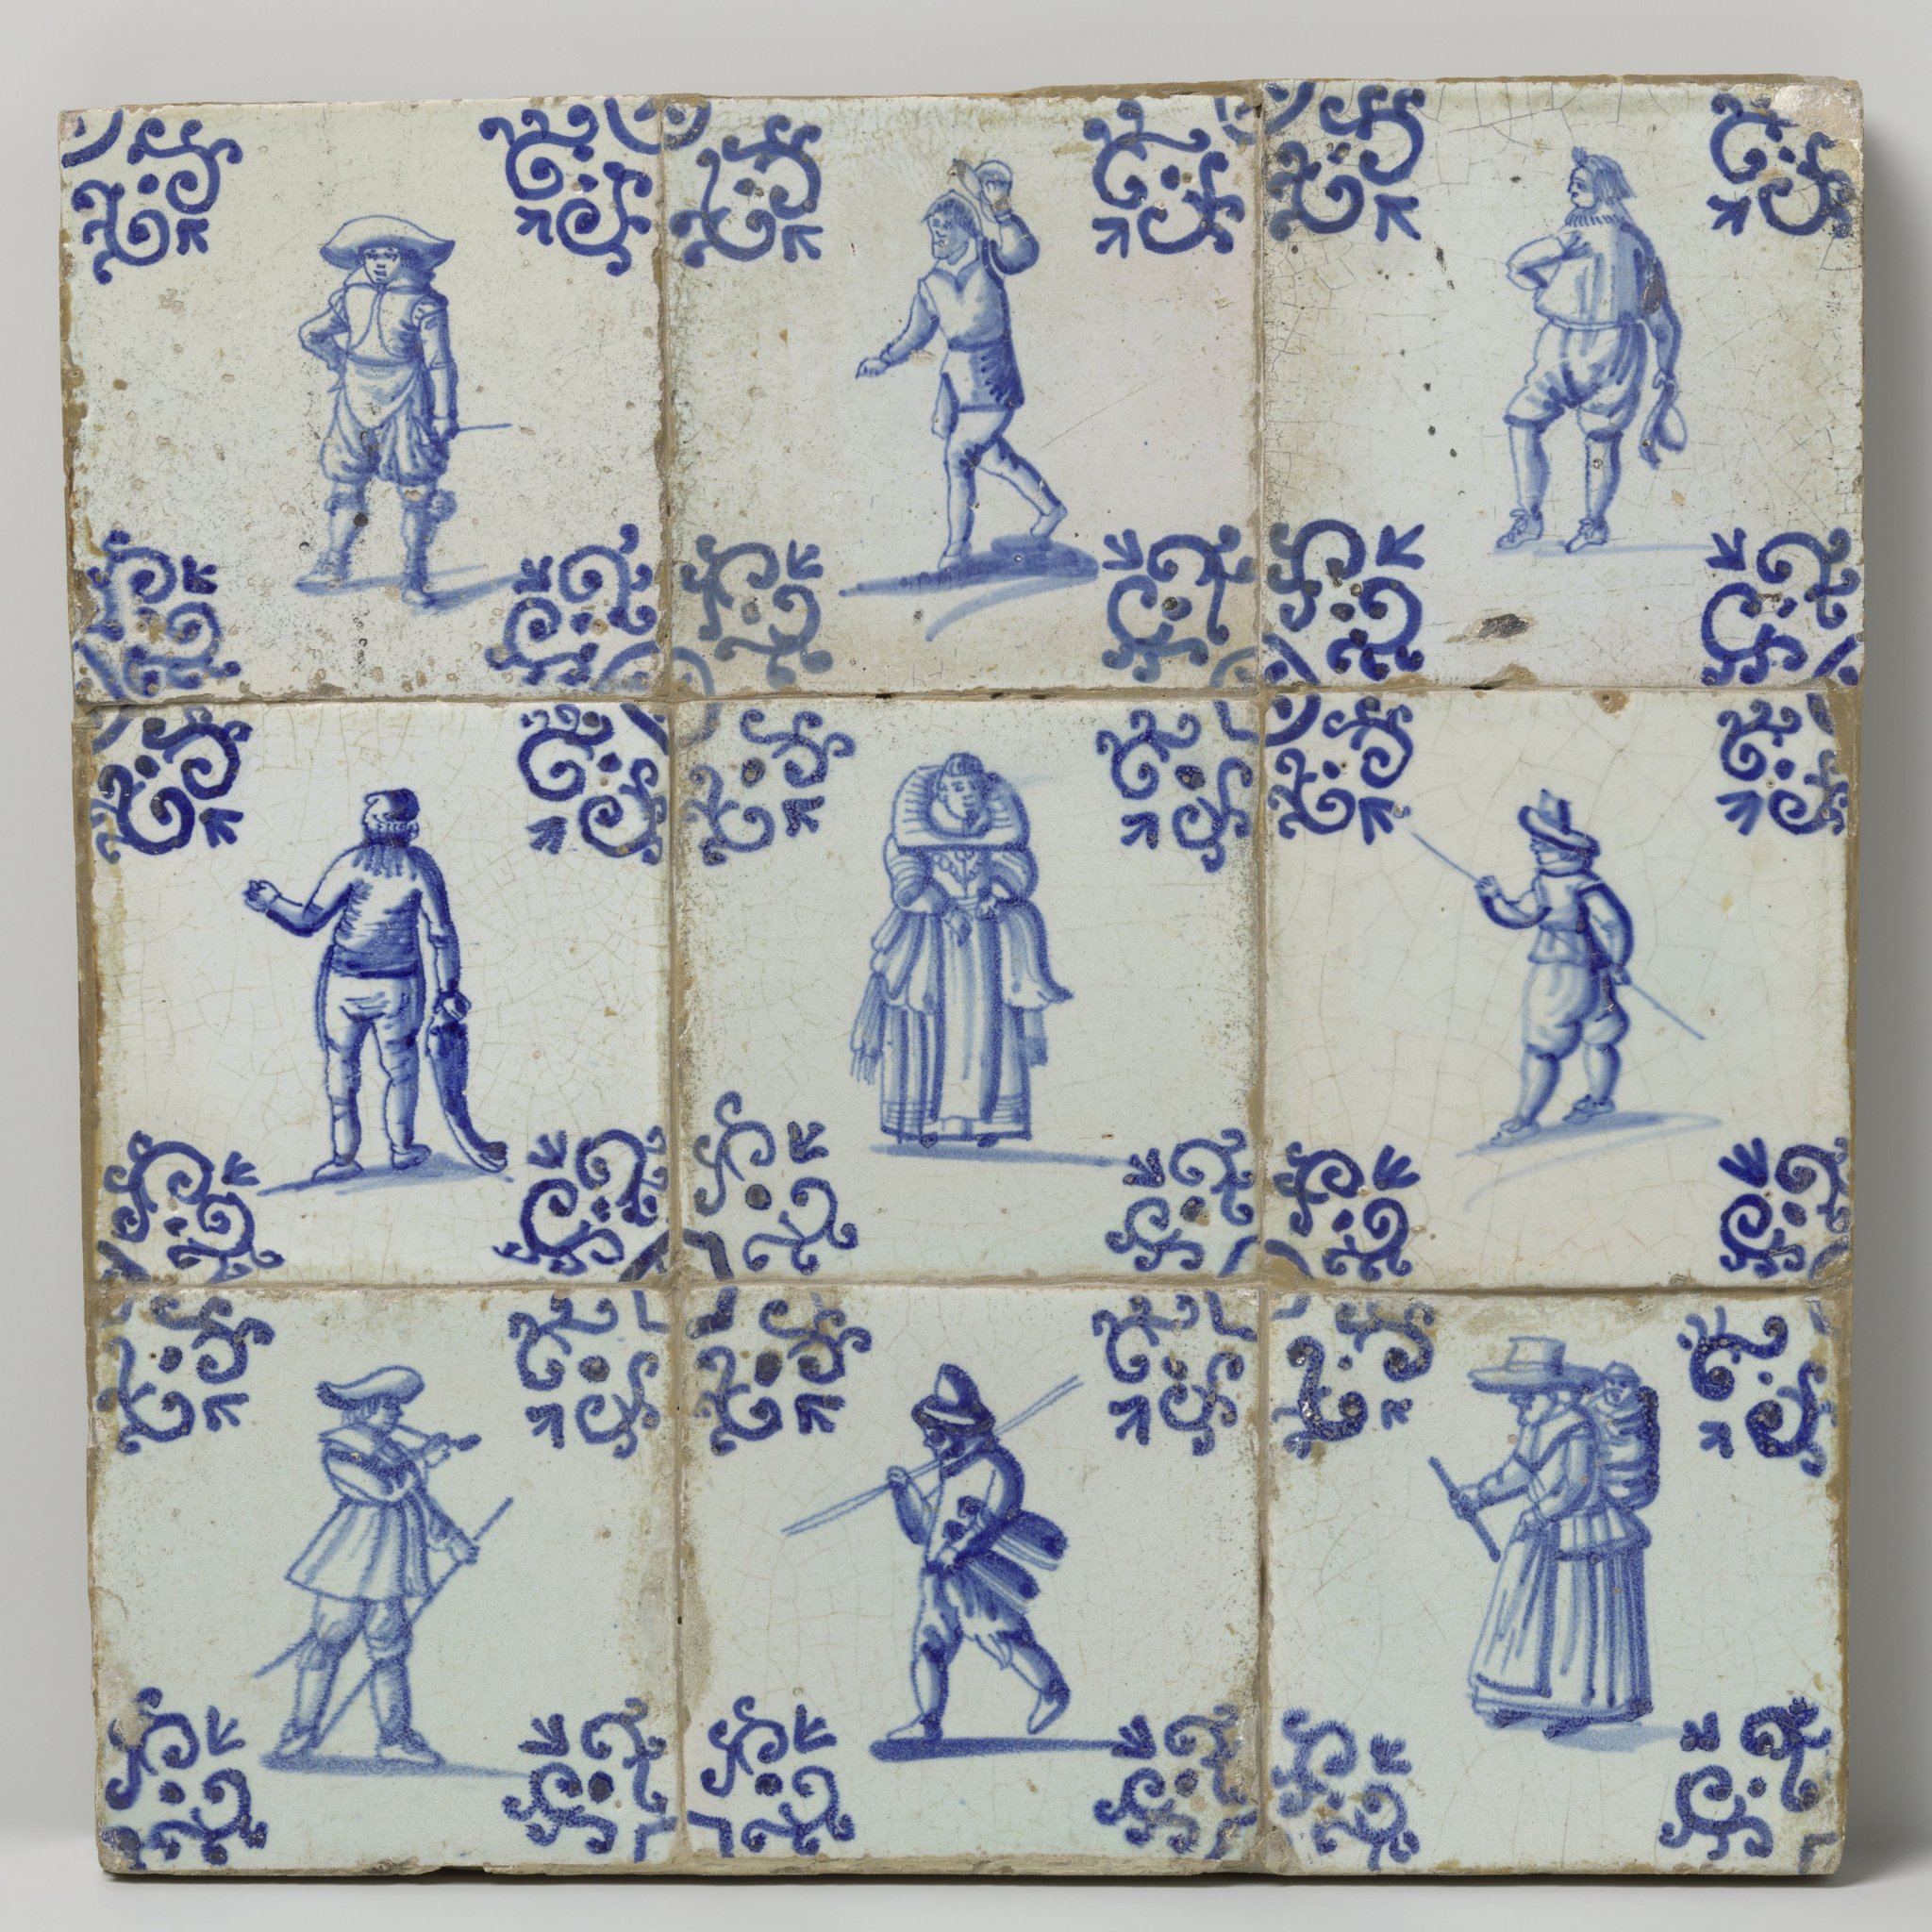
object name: tile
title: Veld van negen tegels met ambachten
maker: Anonymous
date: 1620-1640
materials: earthenware, glaze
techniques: maiolica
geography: netherlands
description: Veld van negen tegels (3 x 3) elk met een blauw geschilderde voorstelling van een ambacht of beroep in de vorm van een persoon. In de hoeken, een ossenkop.